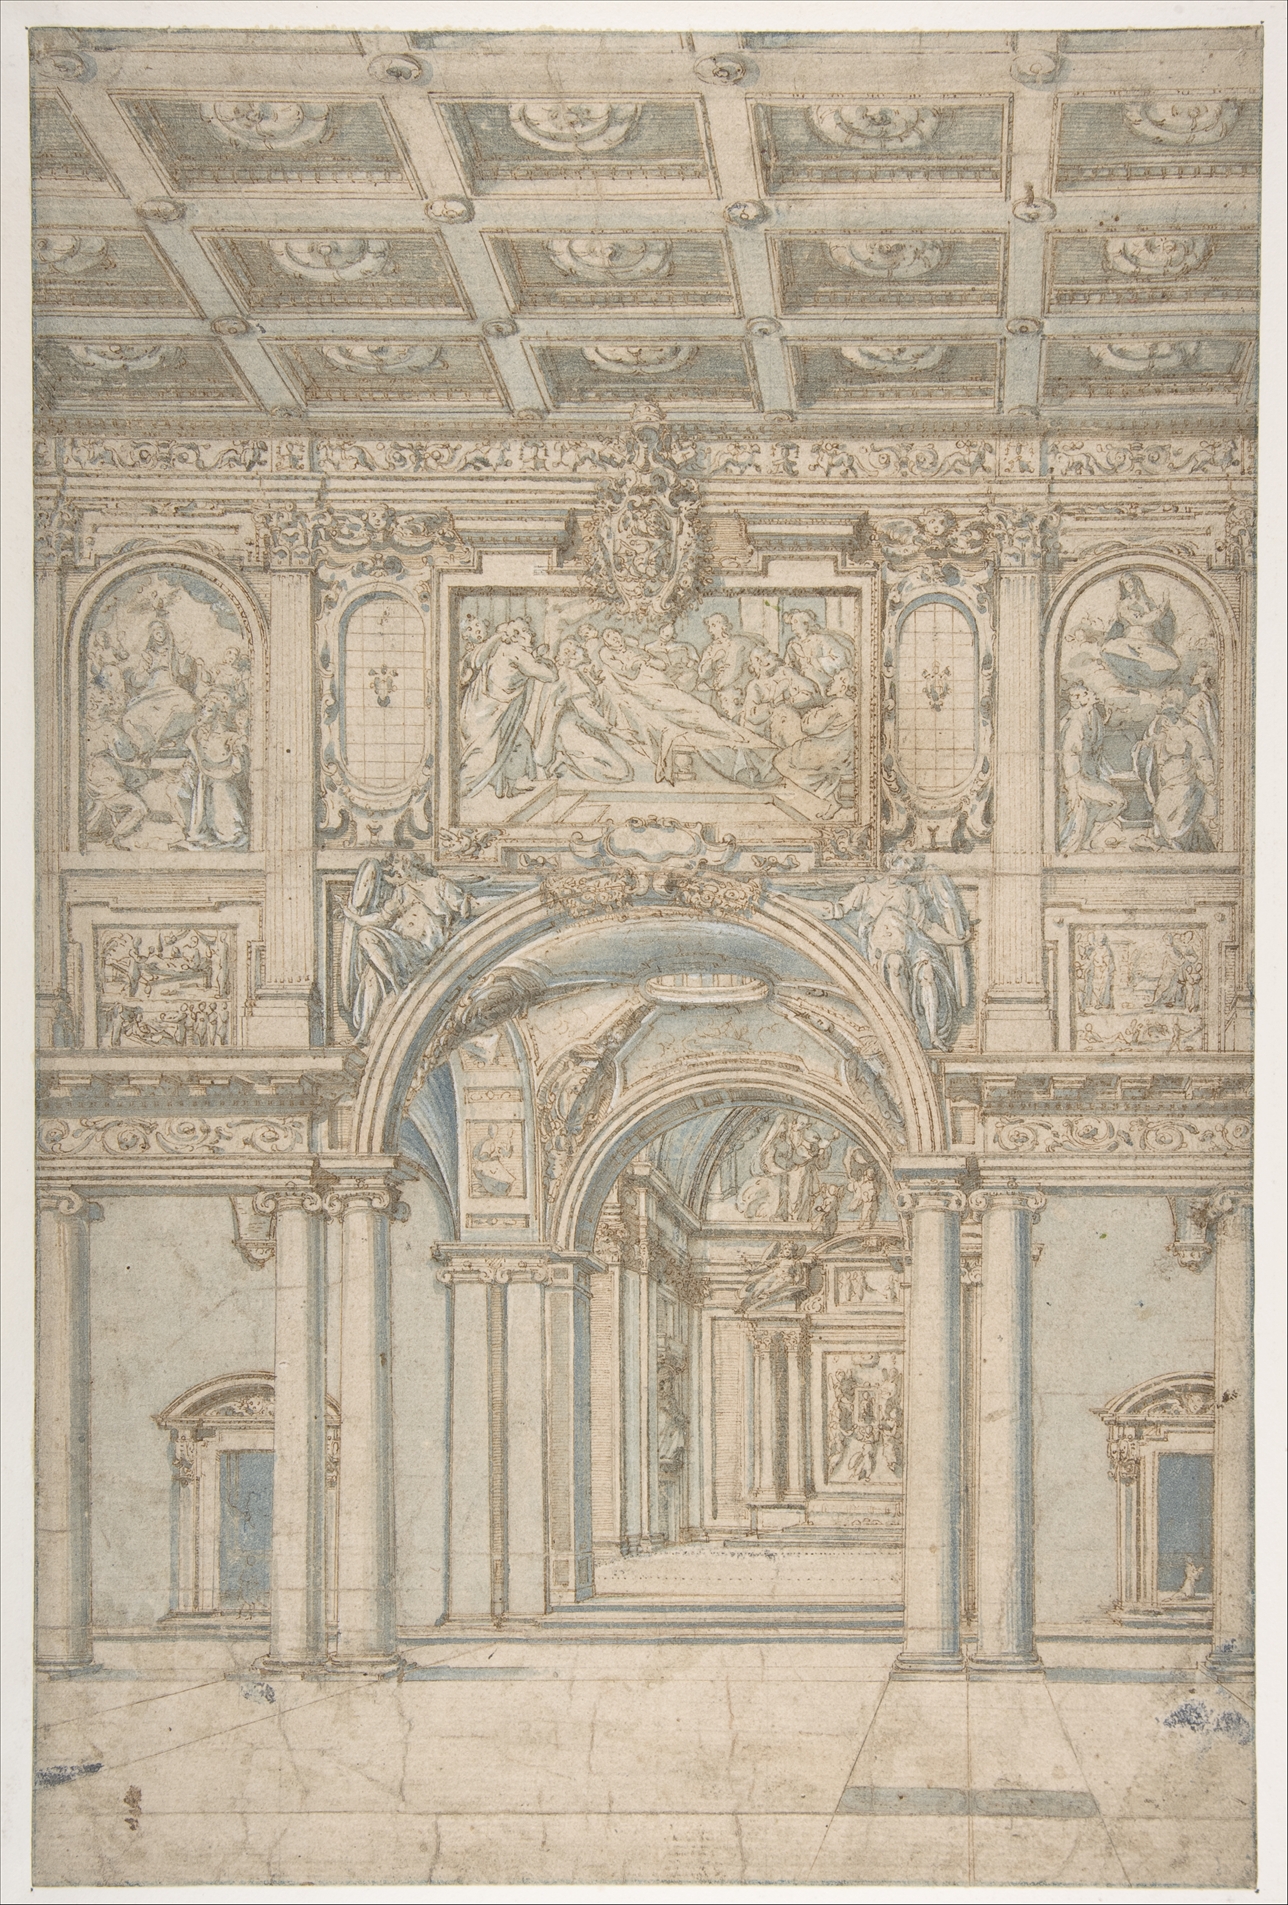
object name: drawing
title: Study of the Interior of Santa Maria Maggiore in Rome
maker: abbate paolo de angelis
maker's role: artist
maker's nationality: italian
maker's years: 1580-1647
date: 1621-1646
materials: gouache, graphite, ink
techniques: brush, highlighting, pen, wash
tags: arches,columns,interiors